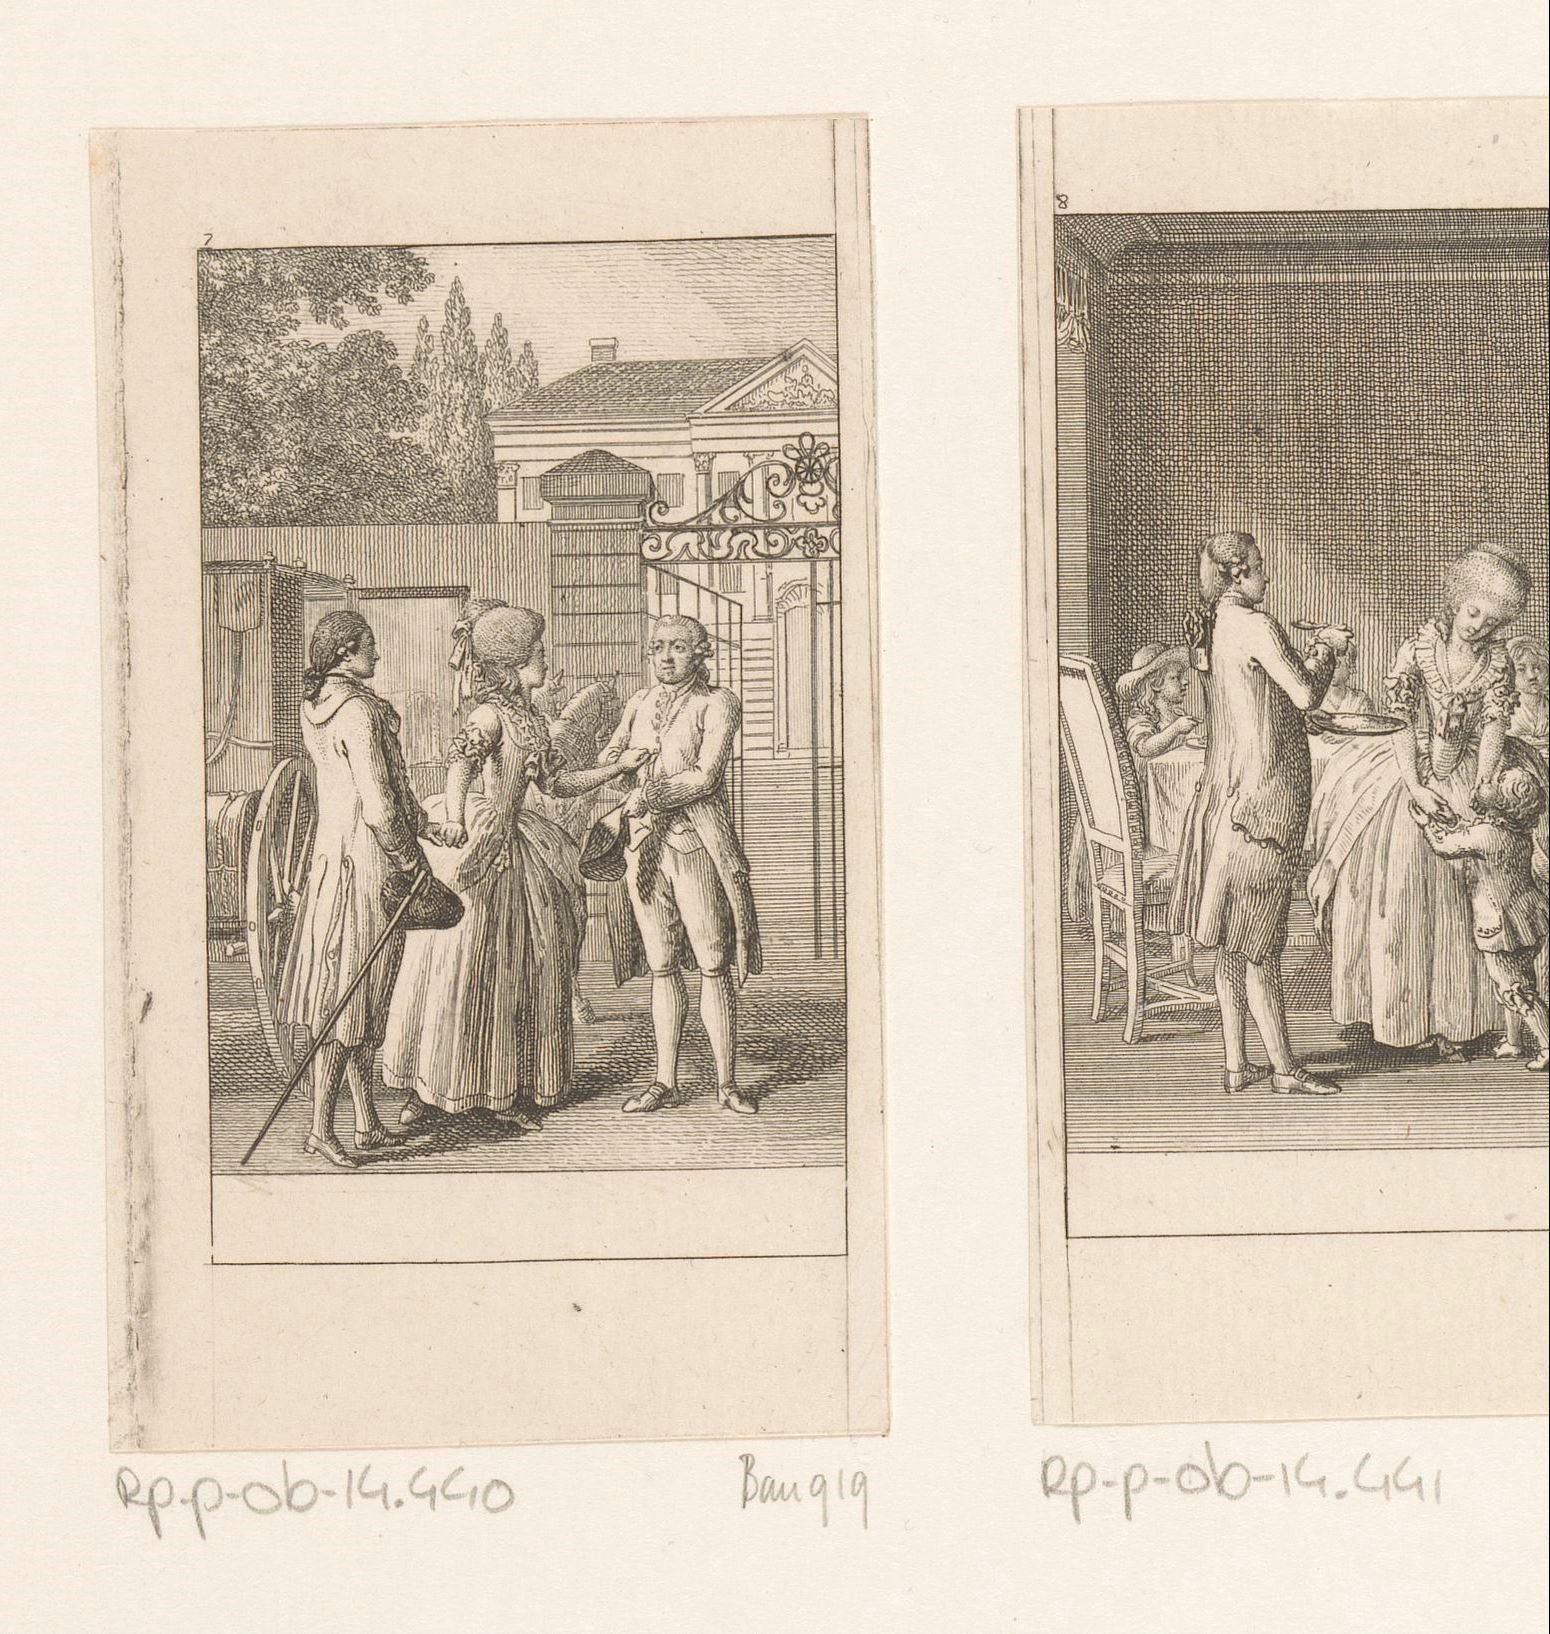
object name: print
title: Julie ontmoet St. Preux na zijn wereldreis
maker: daniel nikolaus chodowiecki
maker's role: draughtsman, print maker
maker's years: 1726-1801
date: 1782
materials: paper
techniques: etching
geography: berlin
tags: four-wheeled, animal-drawn vehicle, e.g.: cab, carriage, coach, gate, entrance, villa, lovers' meeting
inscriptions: collector's mark: Lugt 2228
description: Vervaardigd voor Jean-Jacques Rousseaus 'Neue Héliose'. Latere staat gebruikt voor: Almanac généalogique pour l'année 1783. Berlijn: s.n., 1782.